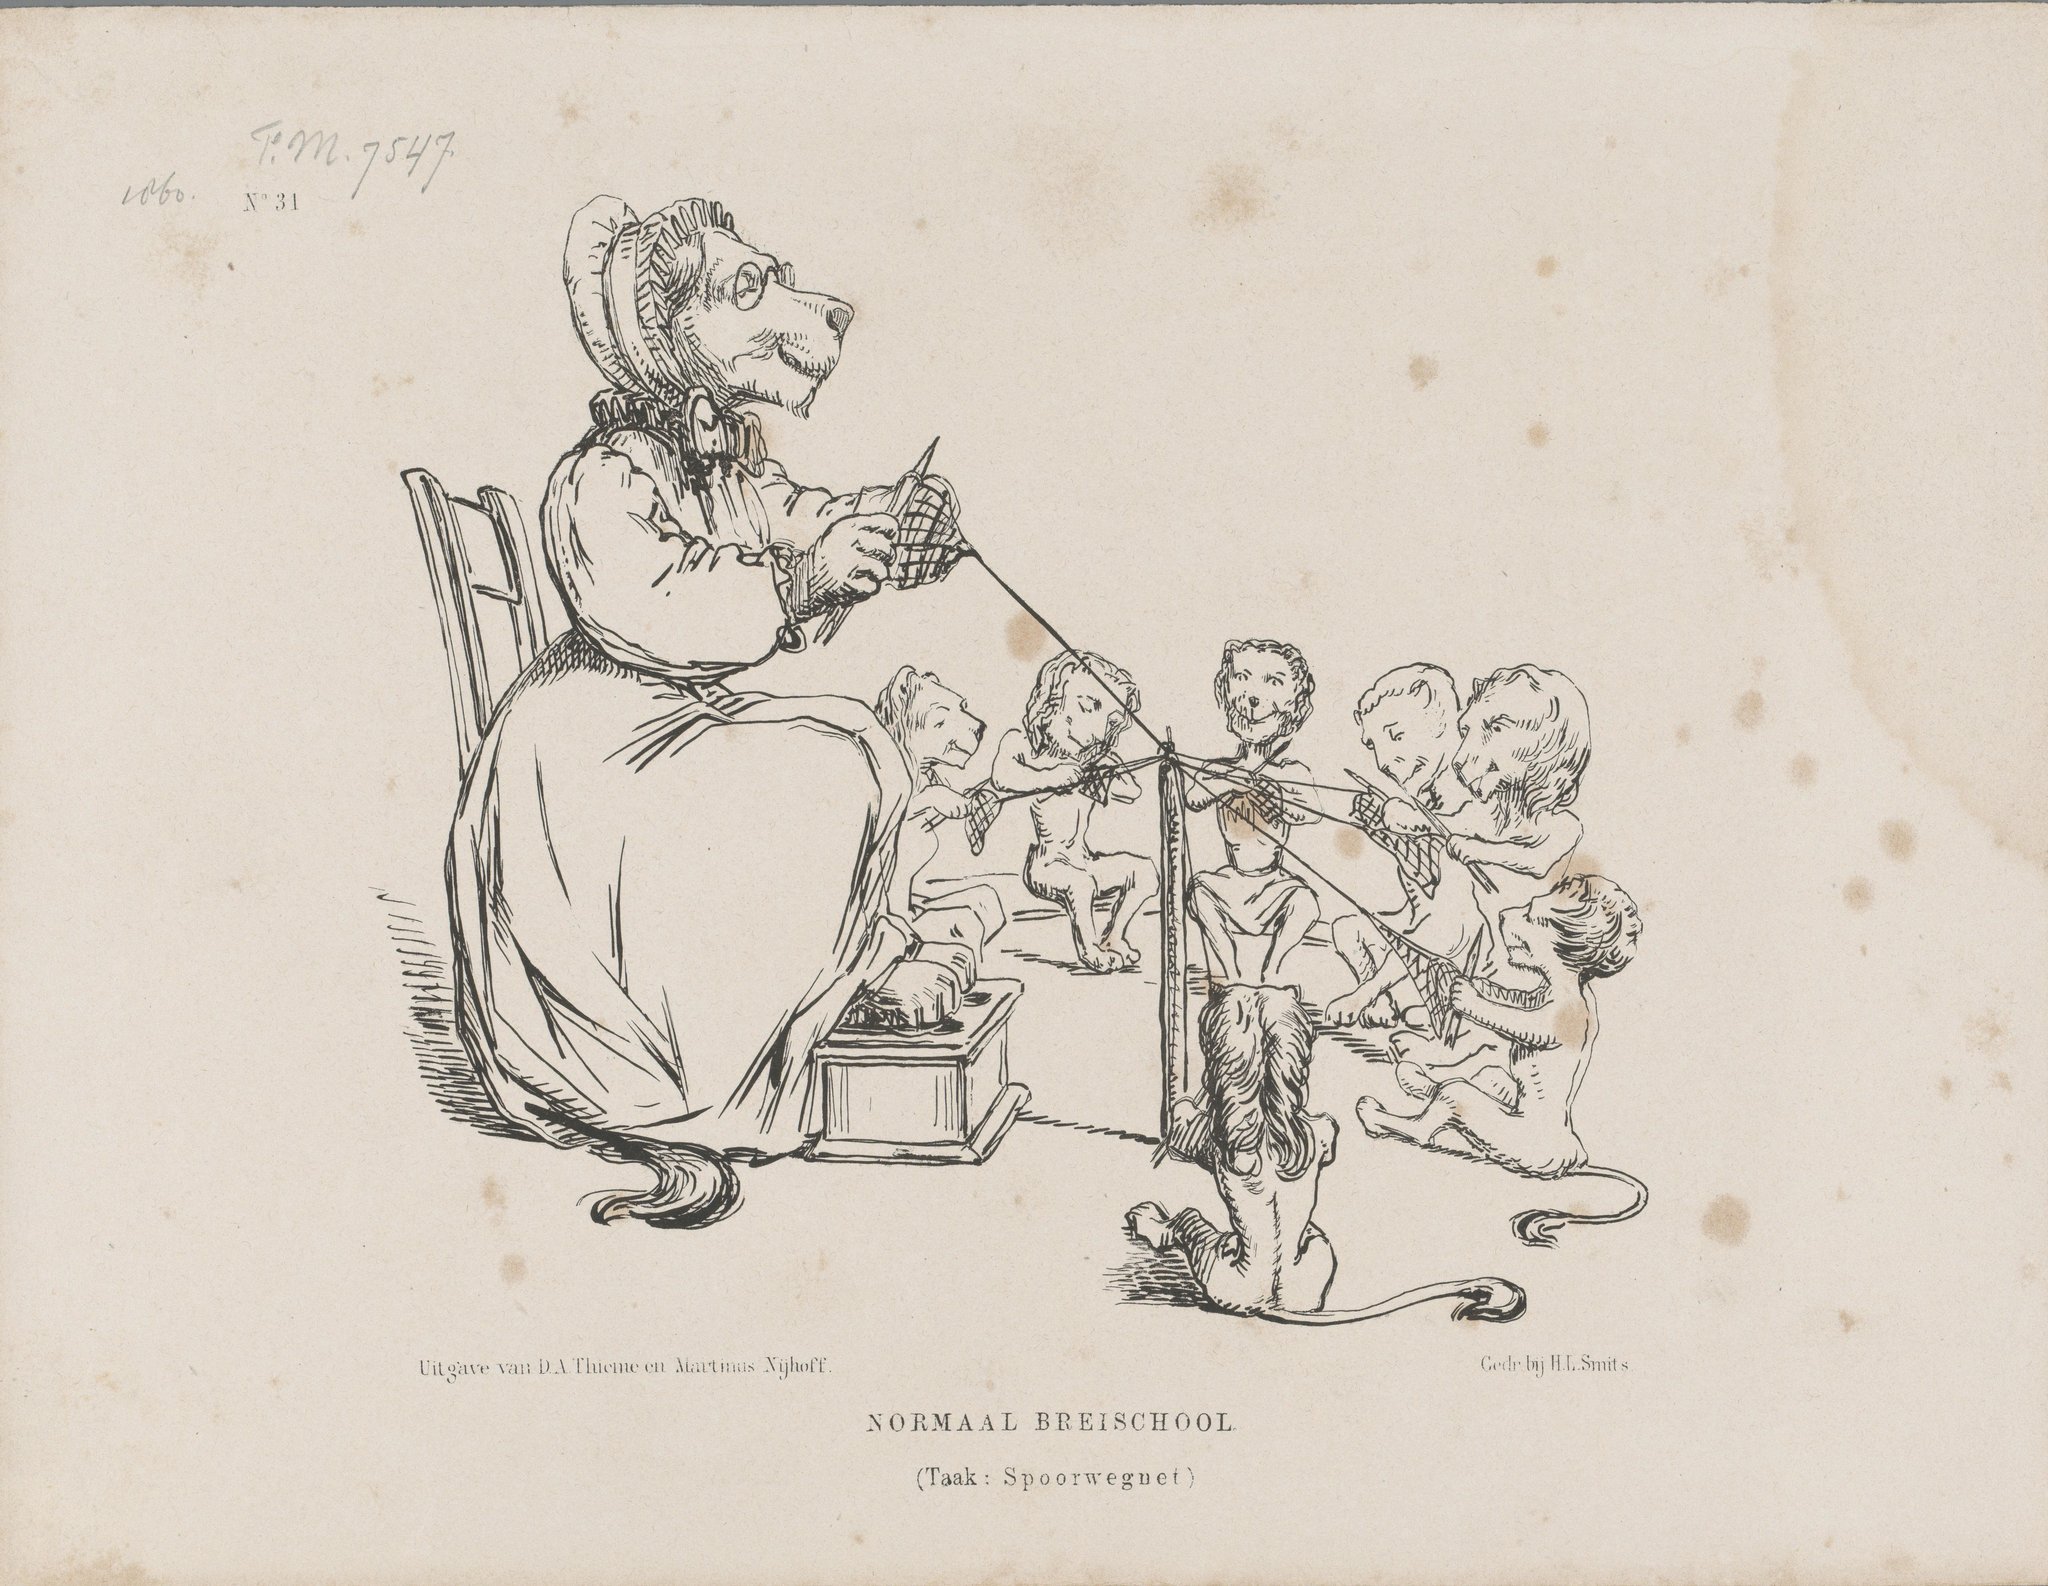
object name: cartoon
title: Spotprent op de aanleg van spoorwegen, 1860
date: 1860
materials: paper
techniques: lithograph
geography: the hague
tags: animals acting as human beings, knitting, beasts of prey, predatory animals: lion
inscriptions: collector's mark: Lugt 2228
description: Spotprent op het feit dat door provinciale naijver de aanleg van spoorwegen op zeven verschillende plaatsen tegelijk moest beginnen. De Nederlandse leeuw als naaischoolhoudster zet met zeven kleine leeuwtjes om zich heen tegelijk een net te breien. Plaat verschenen bij het weekblad De Nederlandsche Spectator, nr. 31, 4 augustus 1860.